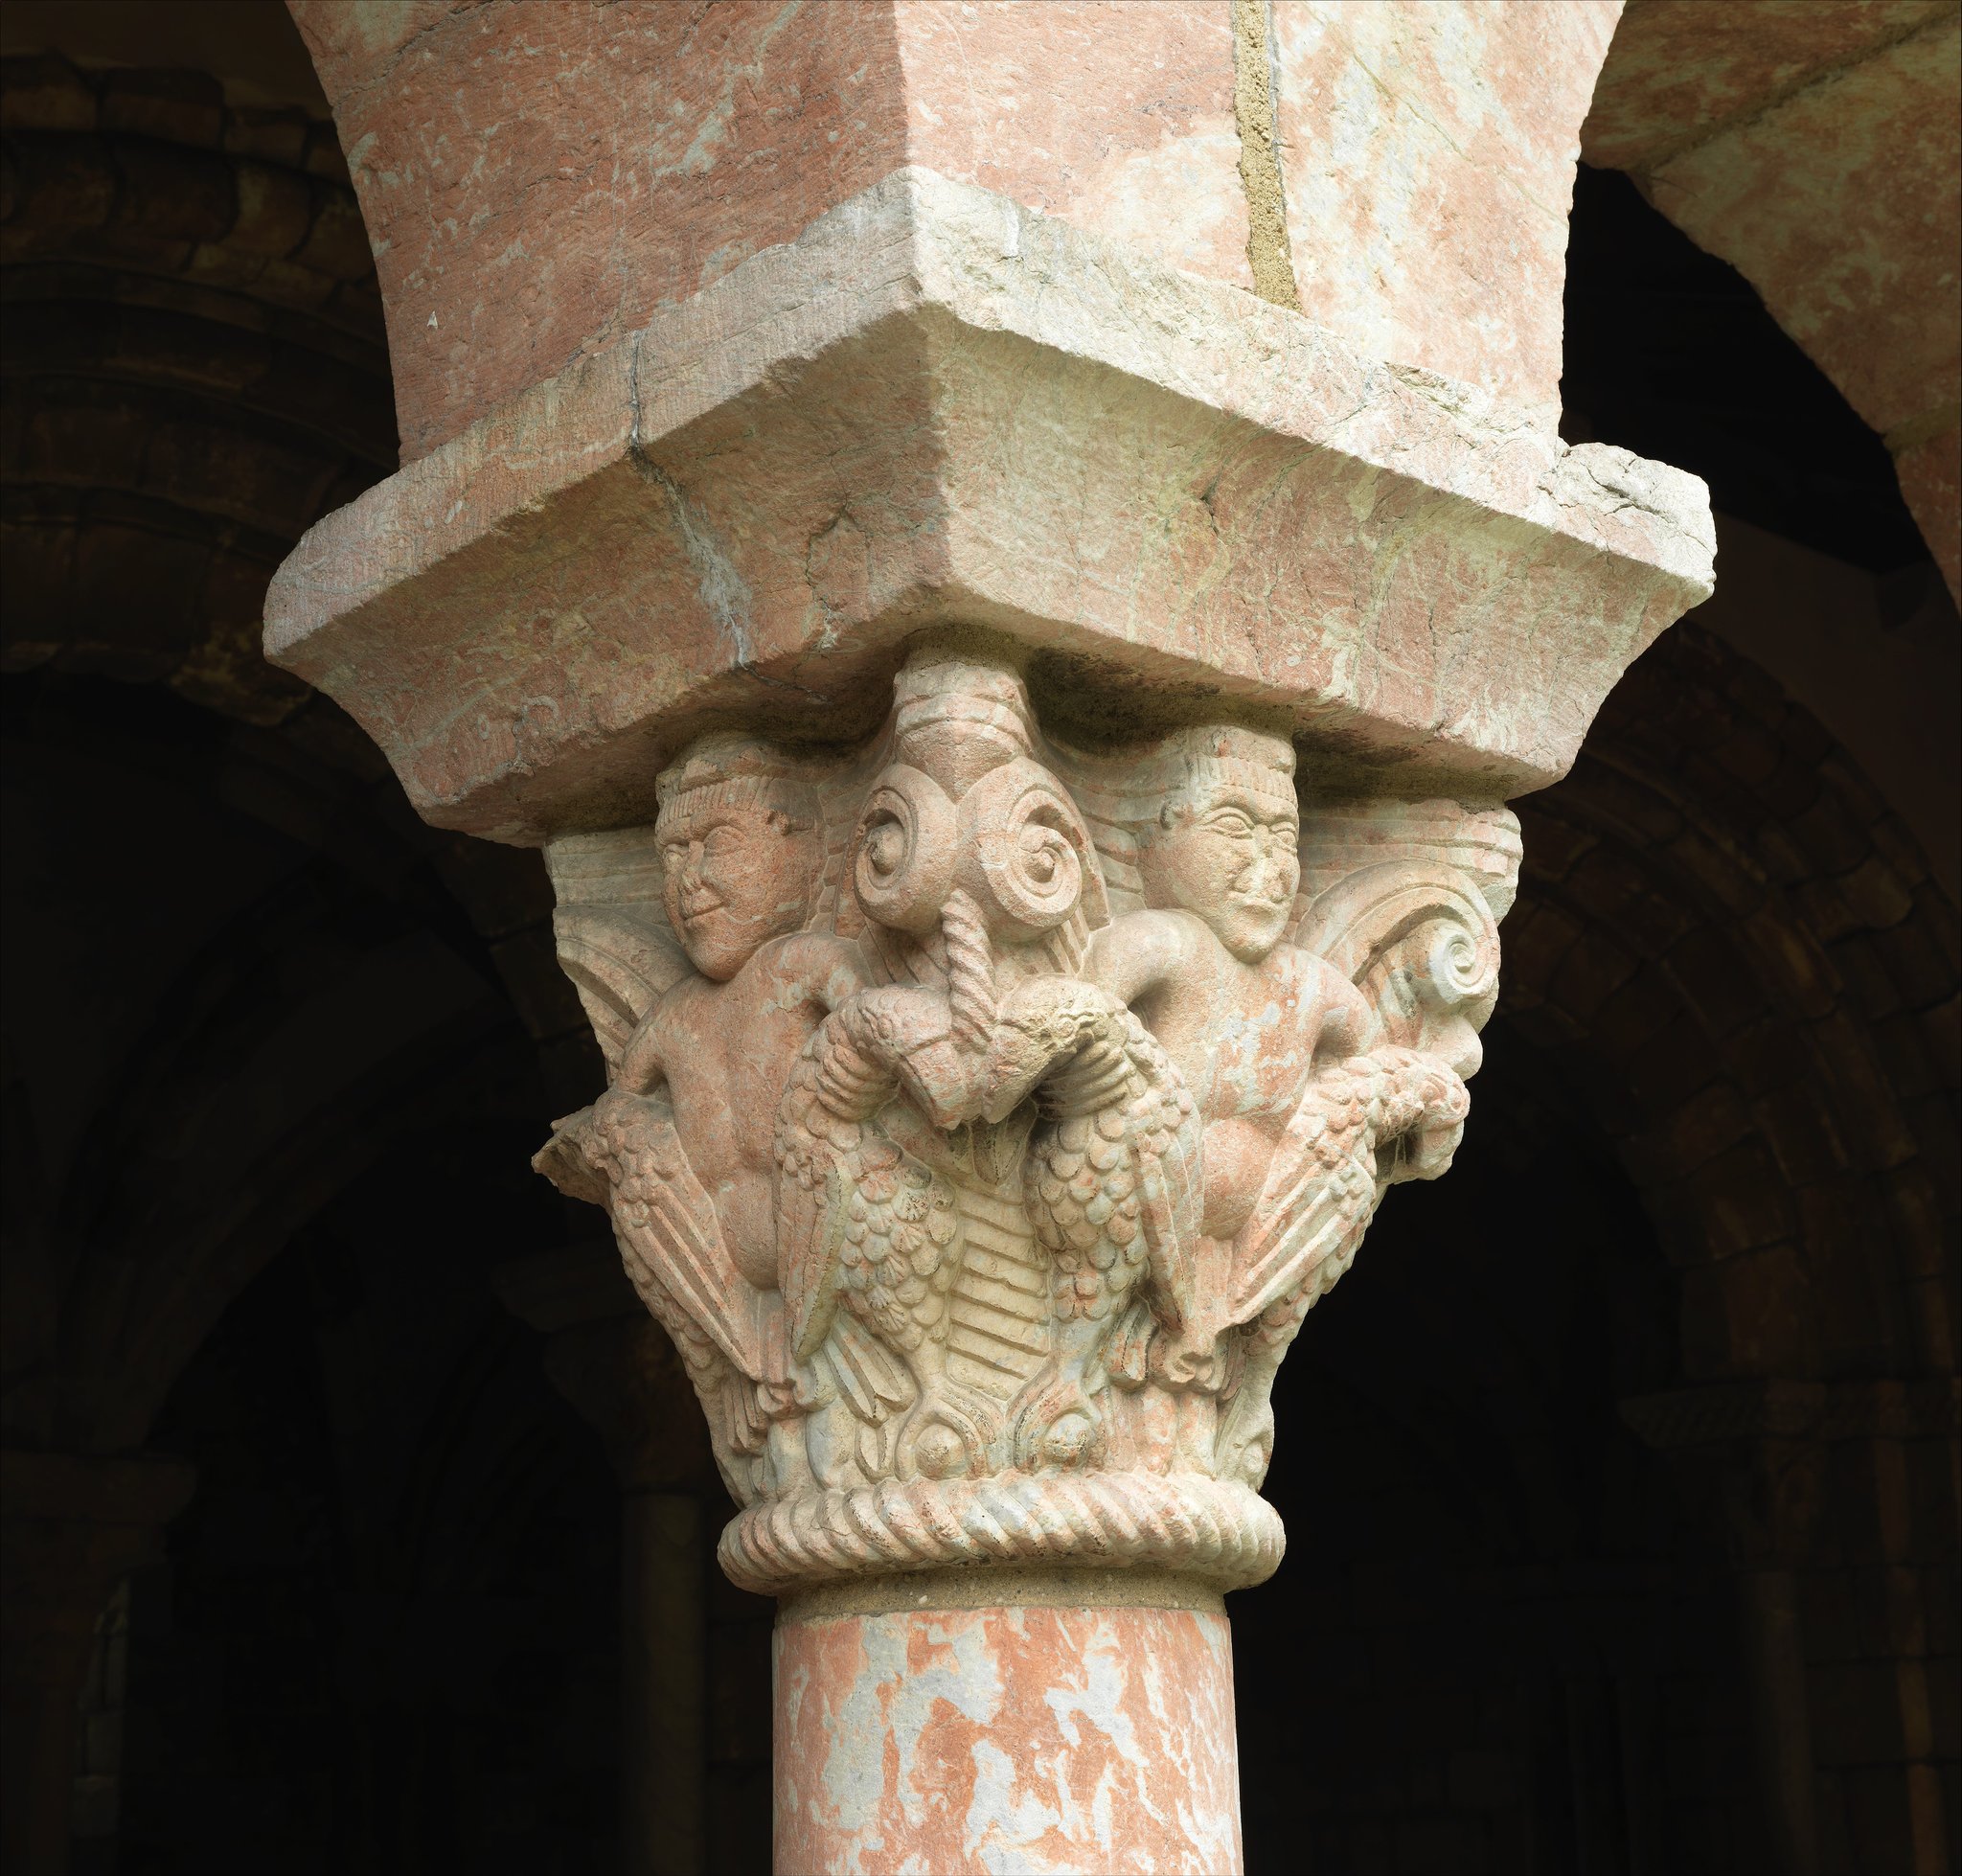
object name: capital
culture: catalan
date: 1130-1140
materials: marble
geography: france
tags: birds,men